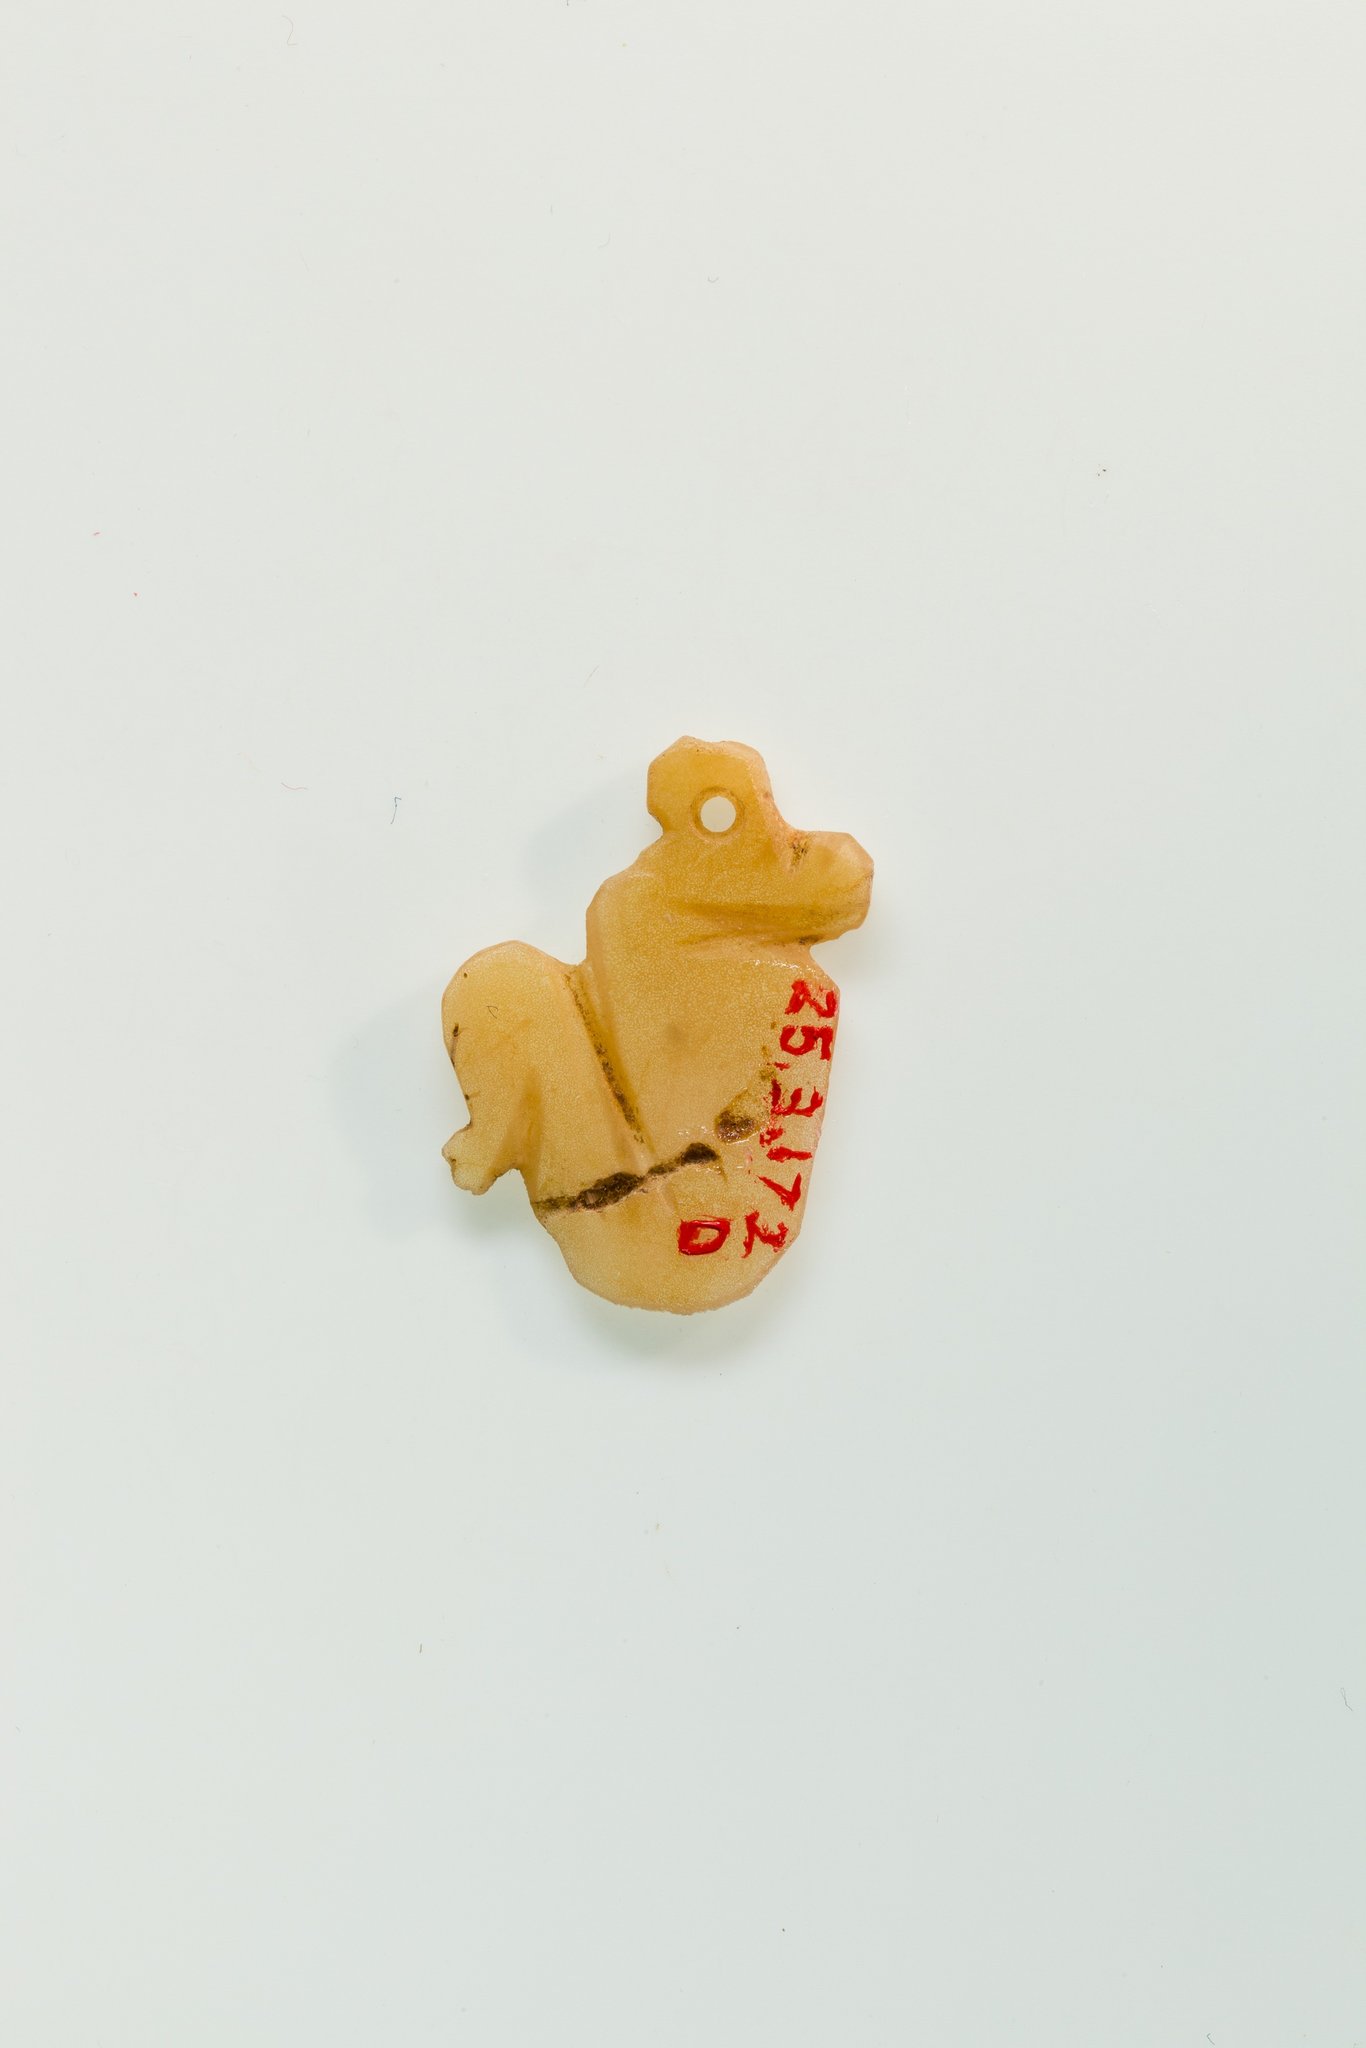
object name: amulet, cobra, tiye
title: Uraeus Amulet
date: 1070-945 BCE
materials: gemstone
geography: egypt